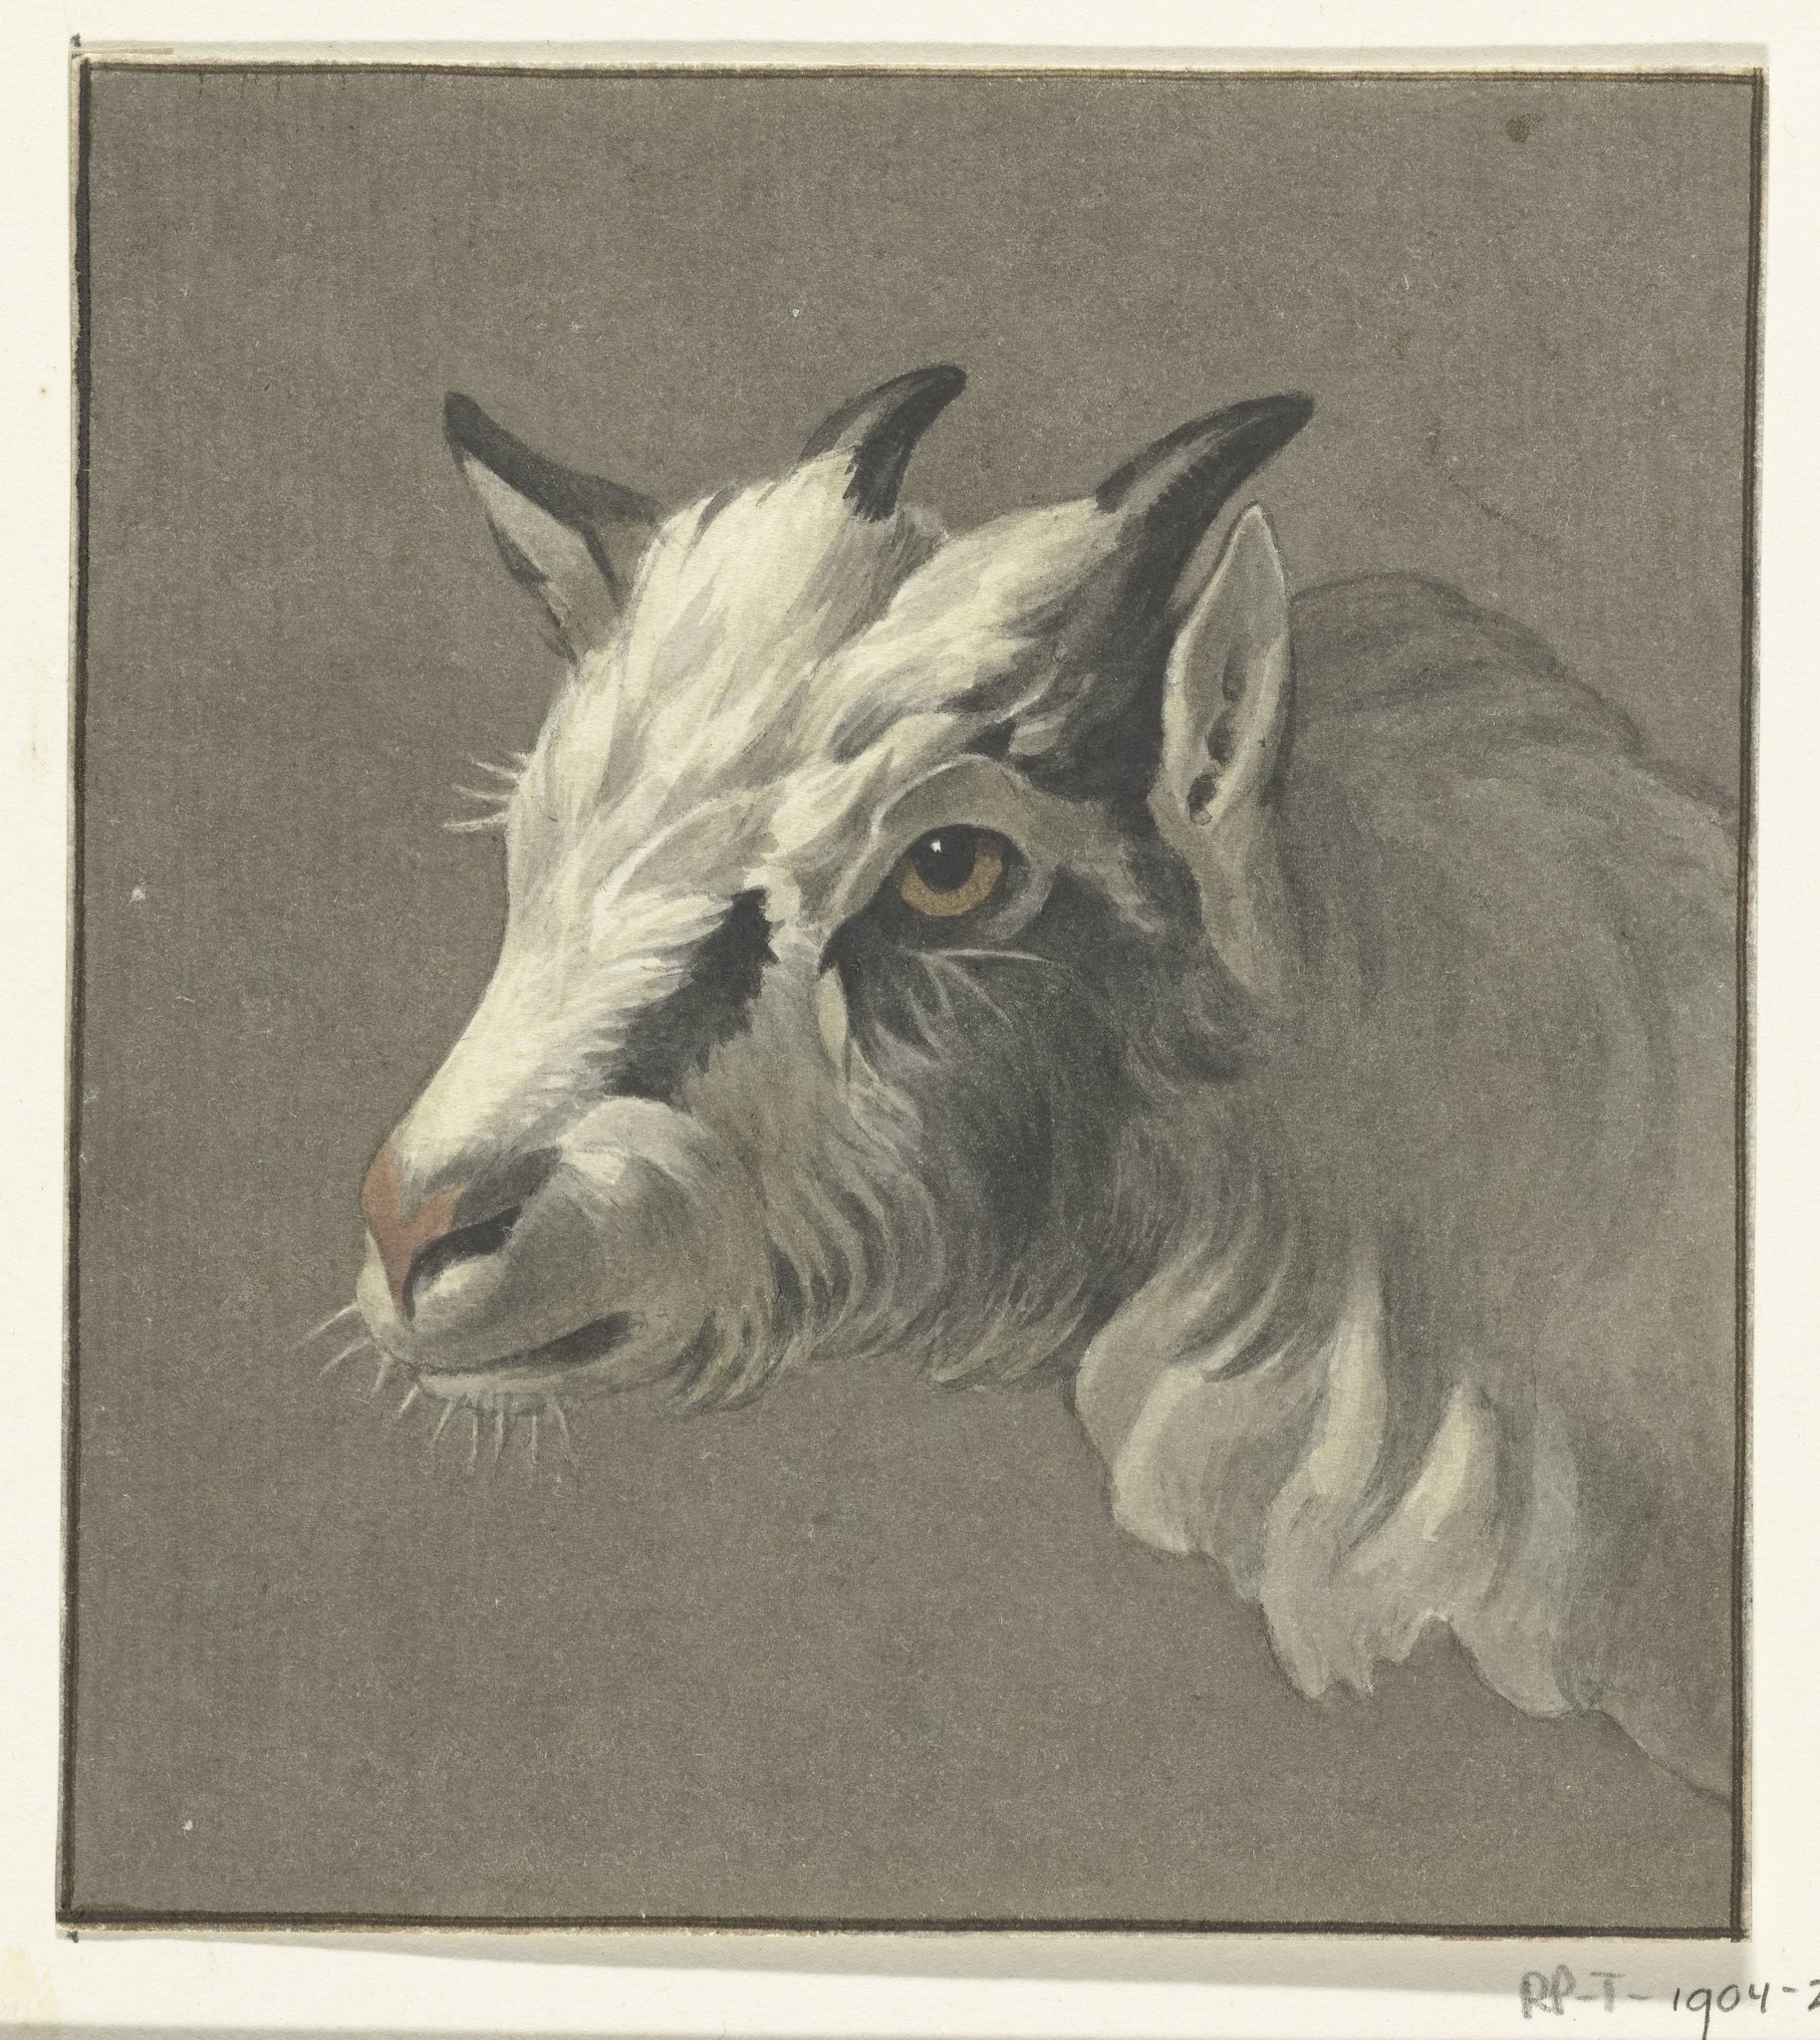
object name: drawing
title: Kop van een geit, naar links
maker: jean bernard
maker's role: draughtsman, print maker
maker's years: 1765-1833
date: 1775-1833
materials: paper, pencil, watercolor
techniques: brush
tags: goat